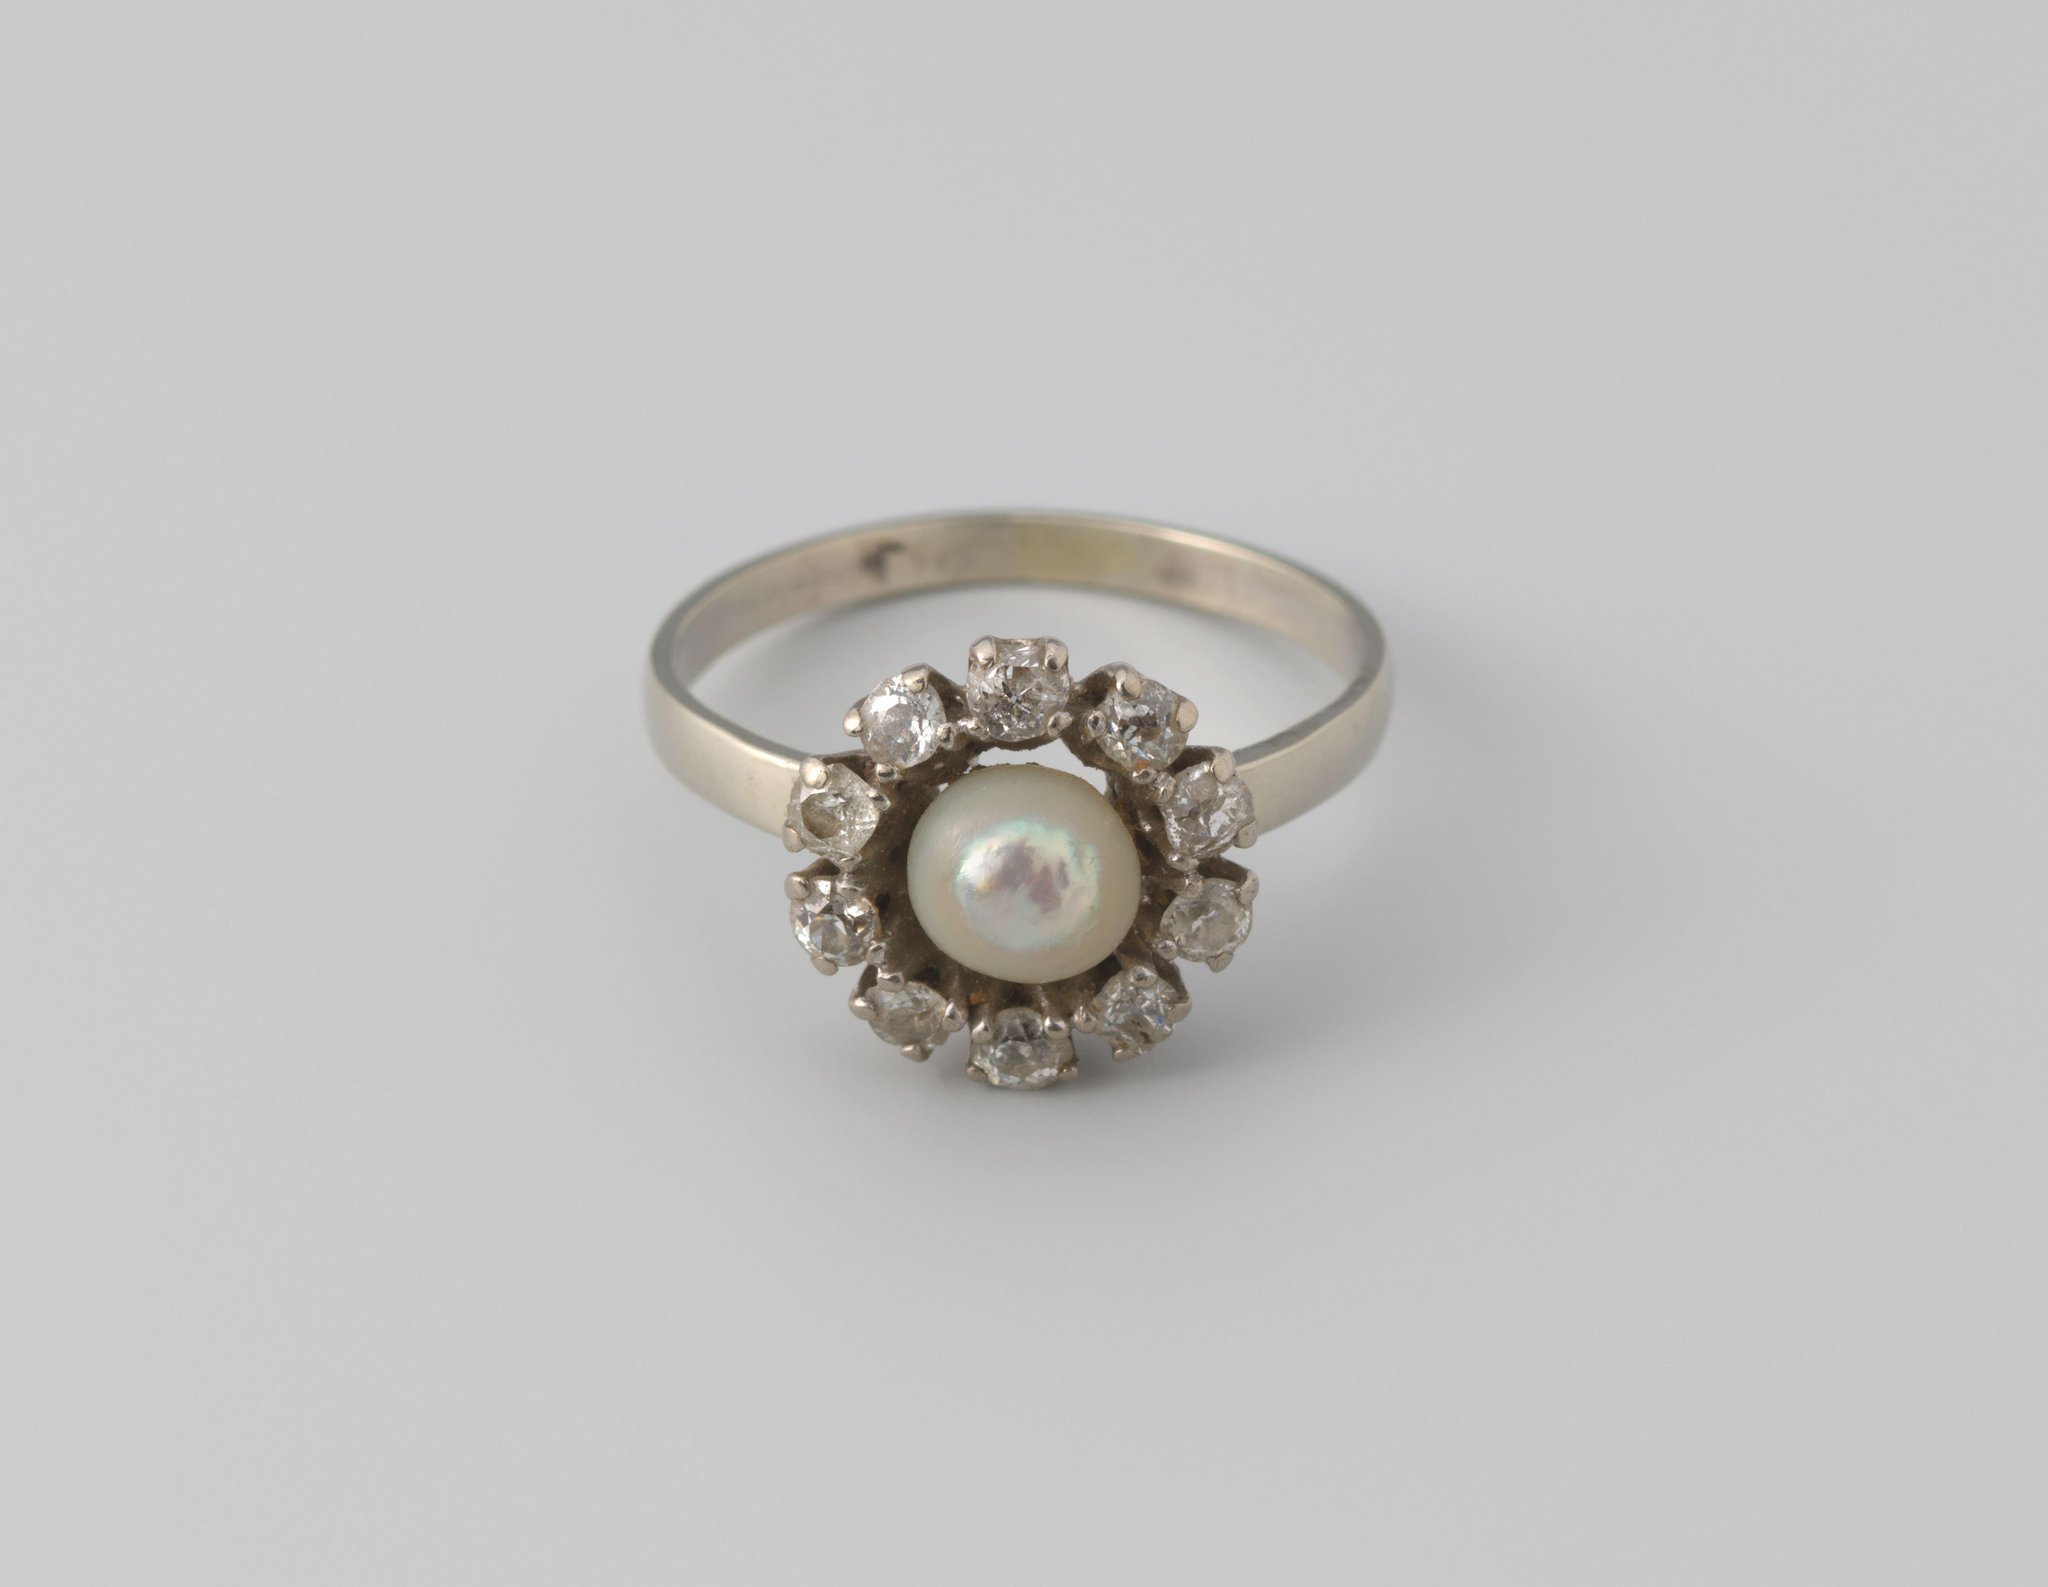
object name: ring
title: Entouragering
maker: Anonymous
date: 1945-1955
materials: diamond, gold alloy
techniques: woodworking, grinding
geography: netherlands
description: Platina of witgouden damesring. De hoep bestaat uit een grote diamant achtkant geslepen omgeven door zes geboorde cultivé parels. Alleen de contouren van de merken zijn nog zichtbaar. Te onderscheiden is het eikenblad, dat tot 1953 in Nederland op gouden voorwerpen werd afgeslagen. Een platina-merk werd pas in 1953 verplicht.